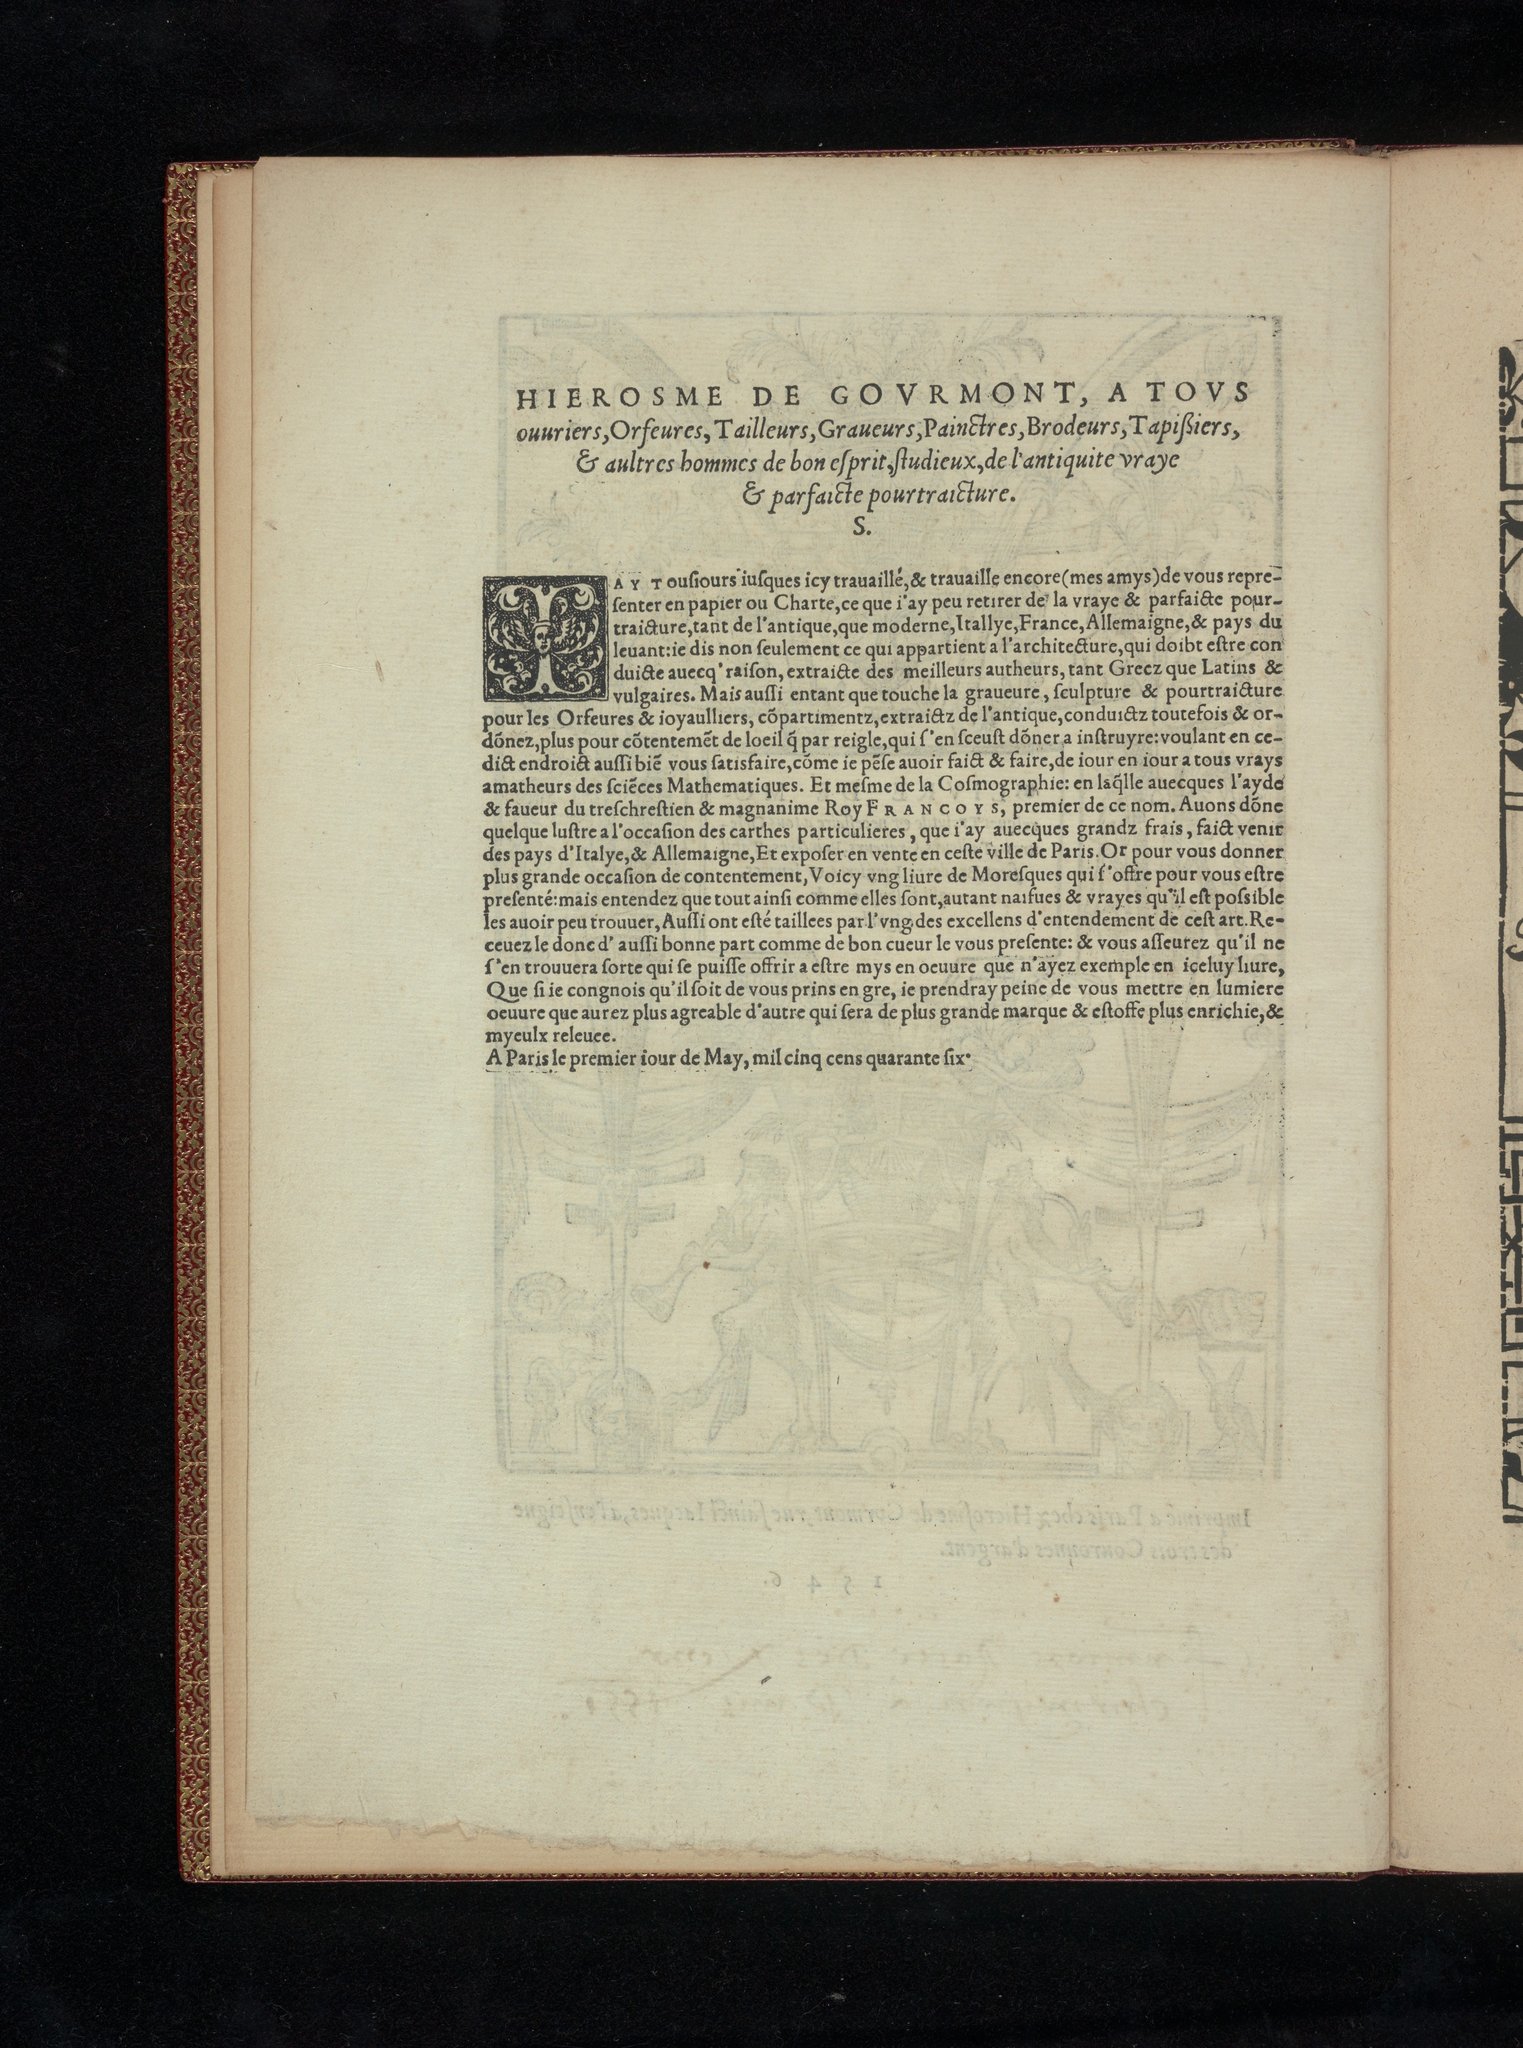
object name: book print ornament architecture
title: Livre de Moresques, title page (verso)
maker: cornelis bos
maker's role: artist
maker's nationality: netherlandish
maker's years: 1510-1556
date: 1546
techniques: woodcut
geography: france